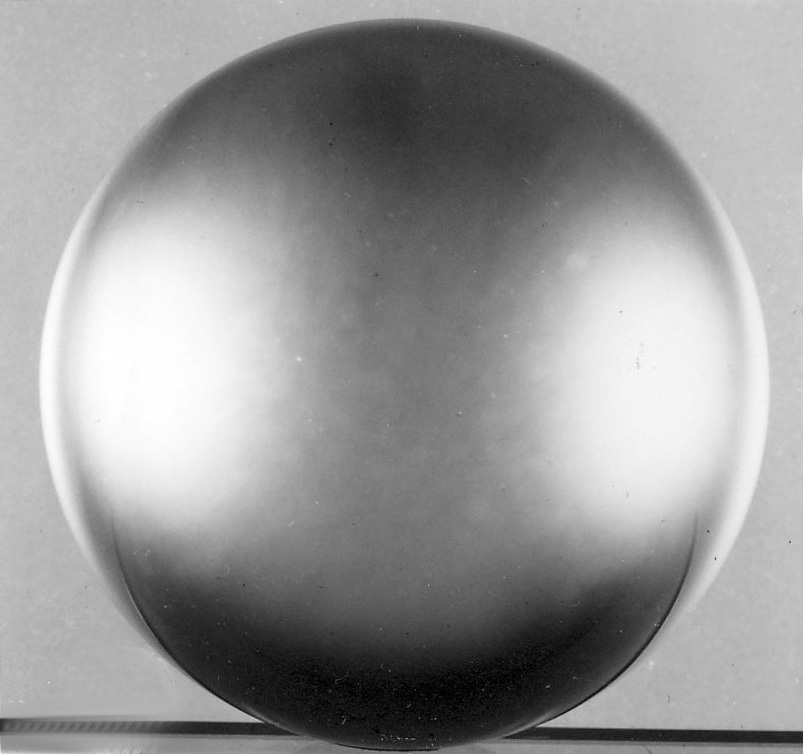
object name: ball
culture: chinese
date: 1801-1900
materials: quartz